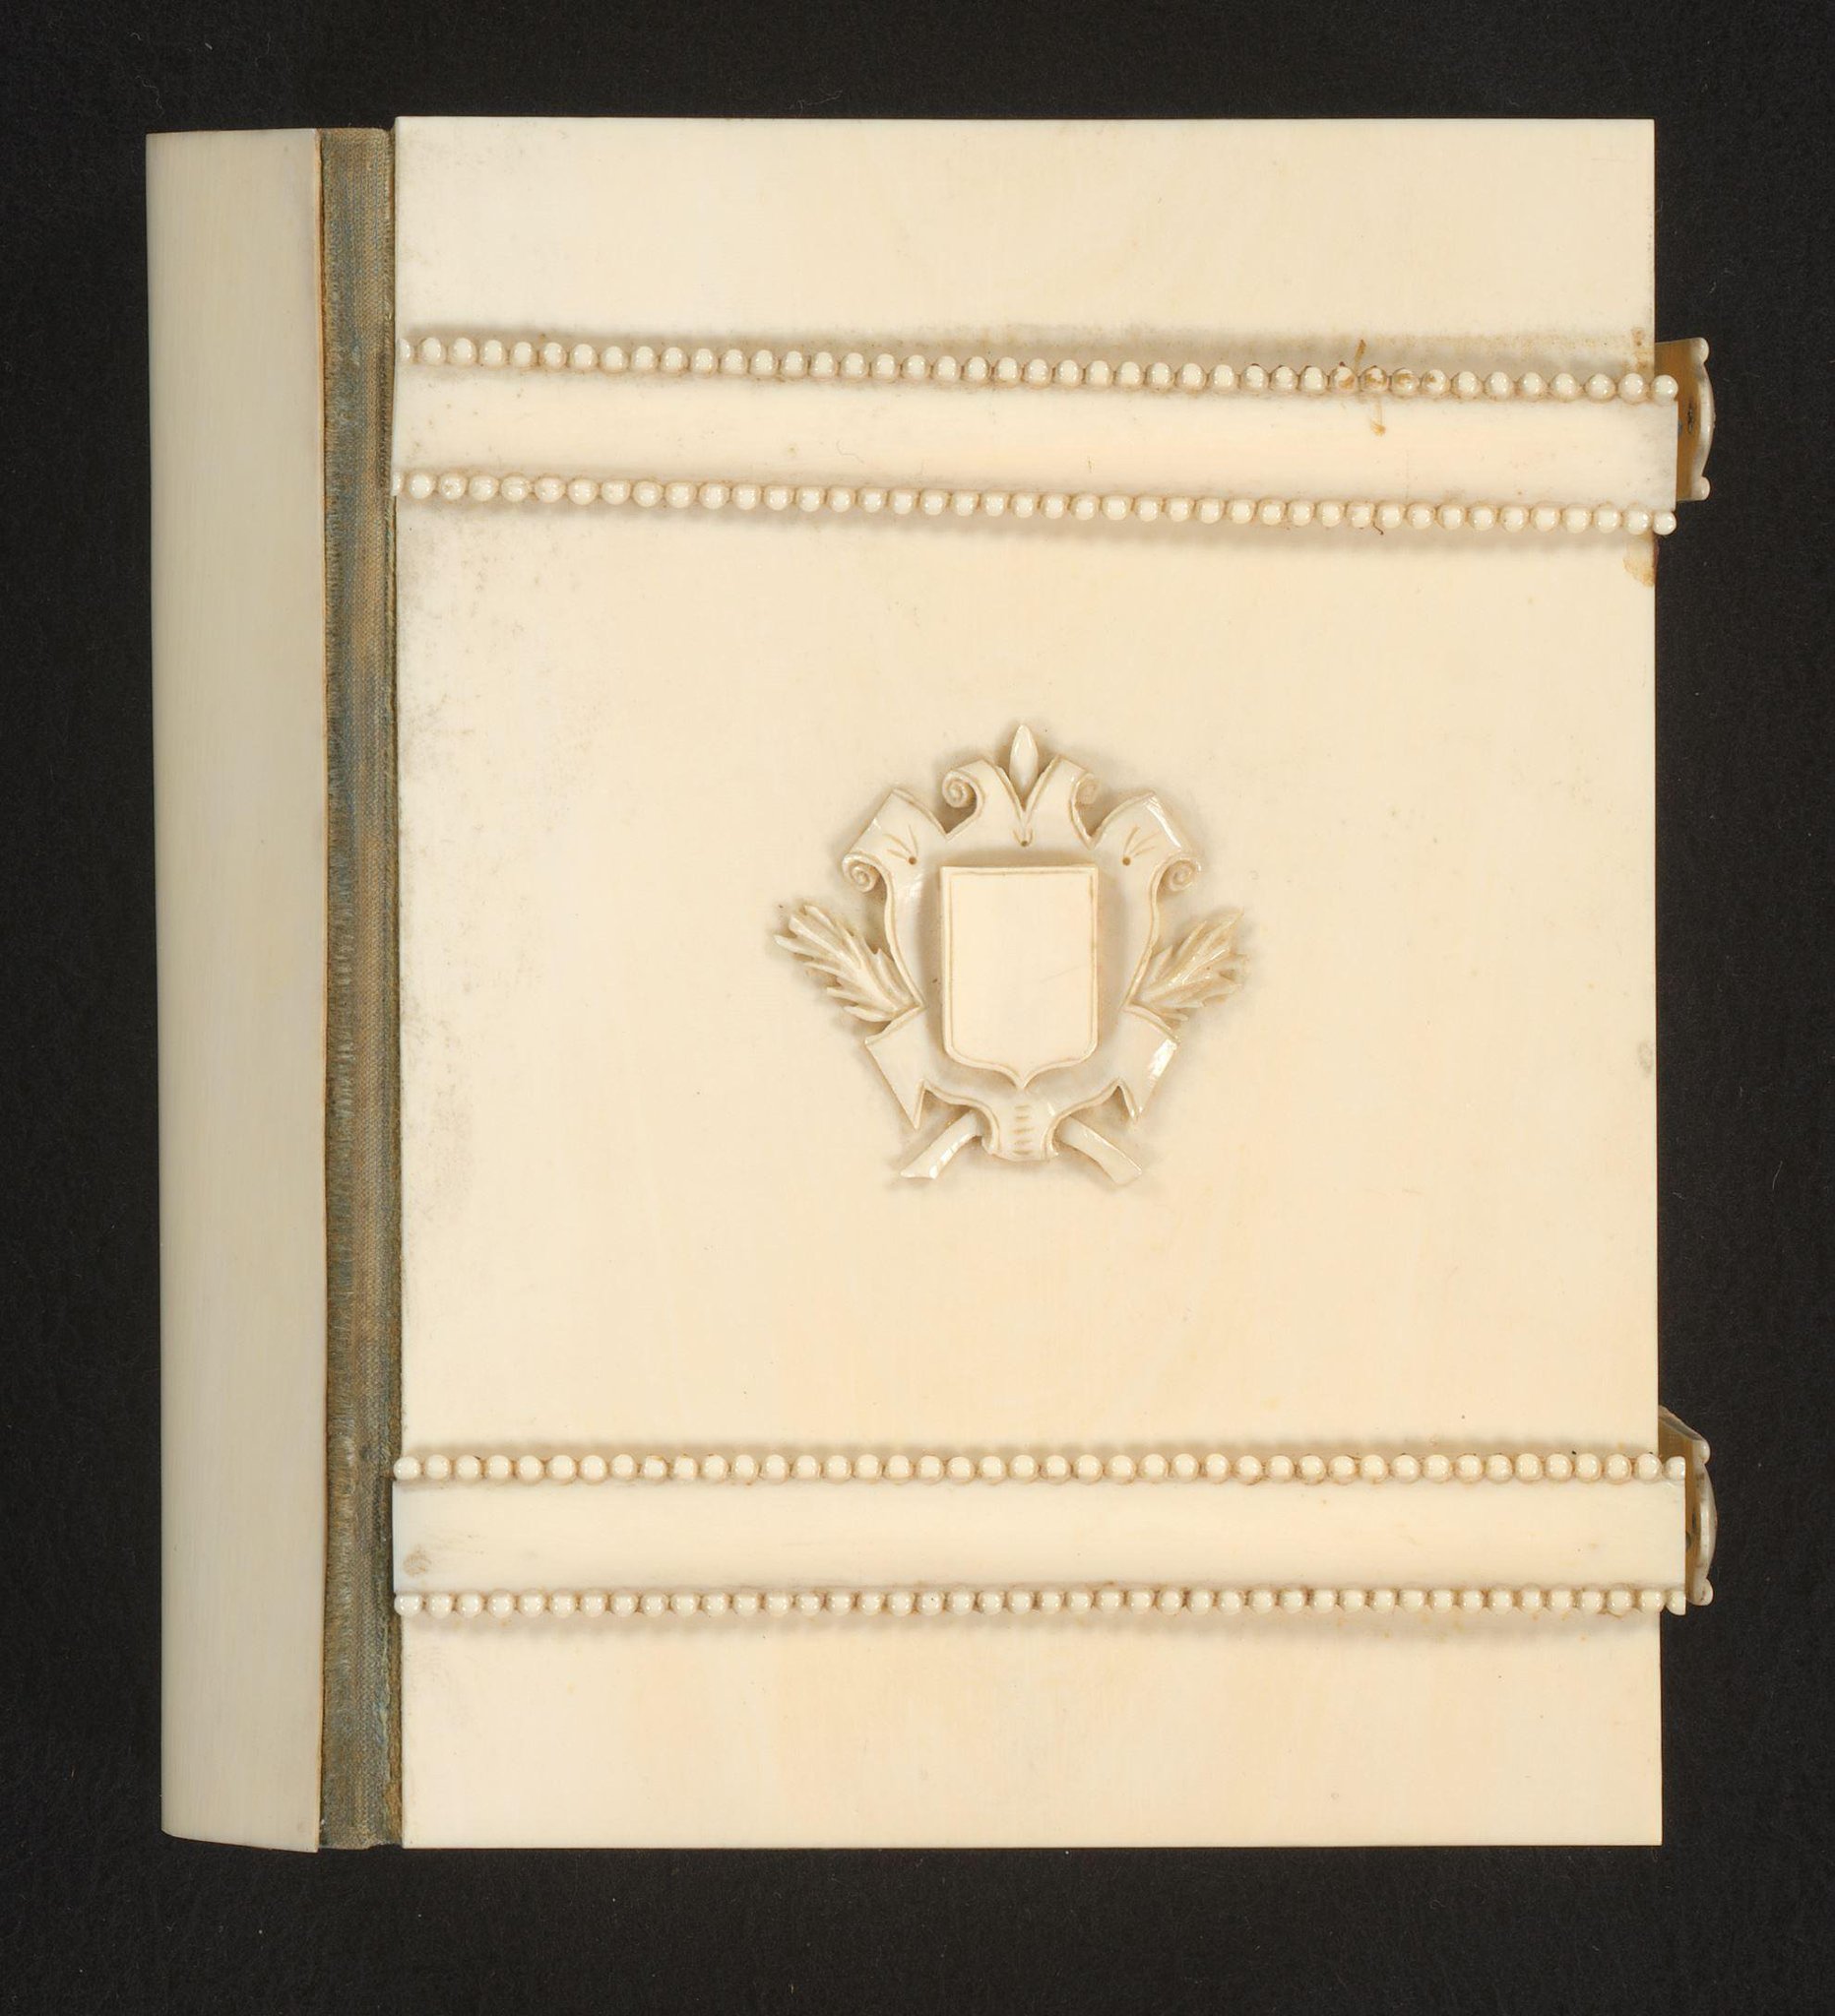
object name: photograph album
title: Fotoalbum (leeg)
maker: Anonymous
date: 1860-1900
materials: cardboard, ivory, linen, metal, paper, silk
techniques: color on snow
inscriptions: collector's mark: ‘DIENST/ VERSPREIDE/ RIJKSKOLLEKTIES/ (...) A 752’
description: Fotoalbum met vijftig pagina's met ieder een met gepreegde rand omkaderde passe-partout voor een carte-de-visite. De passe-partouts zijn afwisselend ovaal en rechthoekig van vorm.